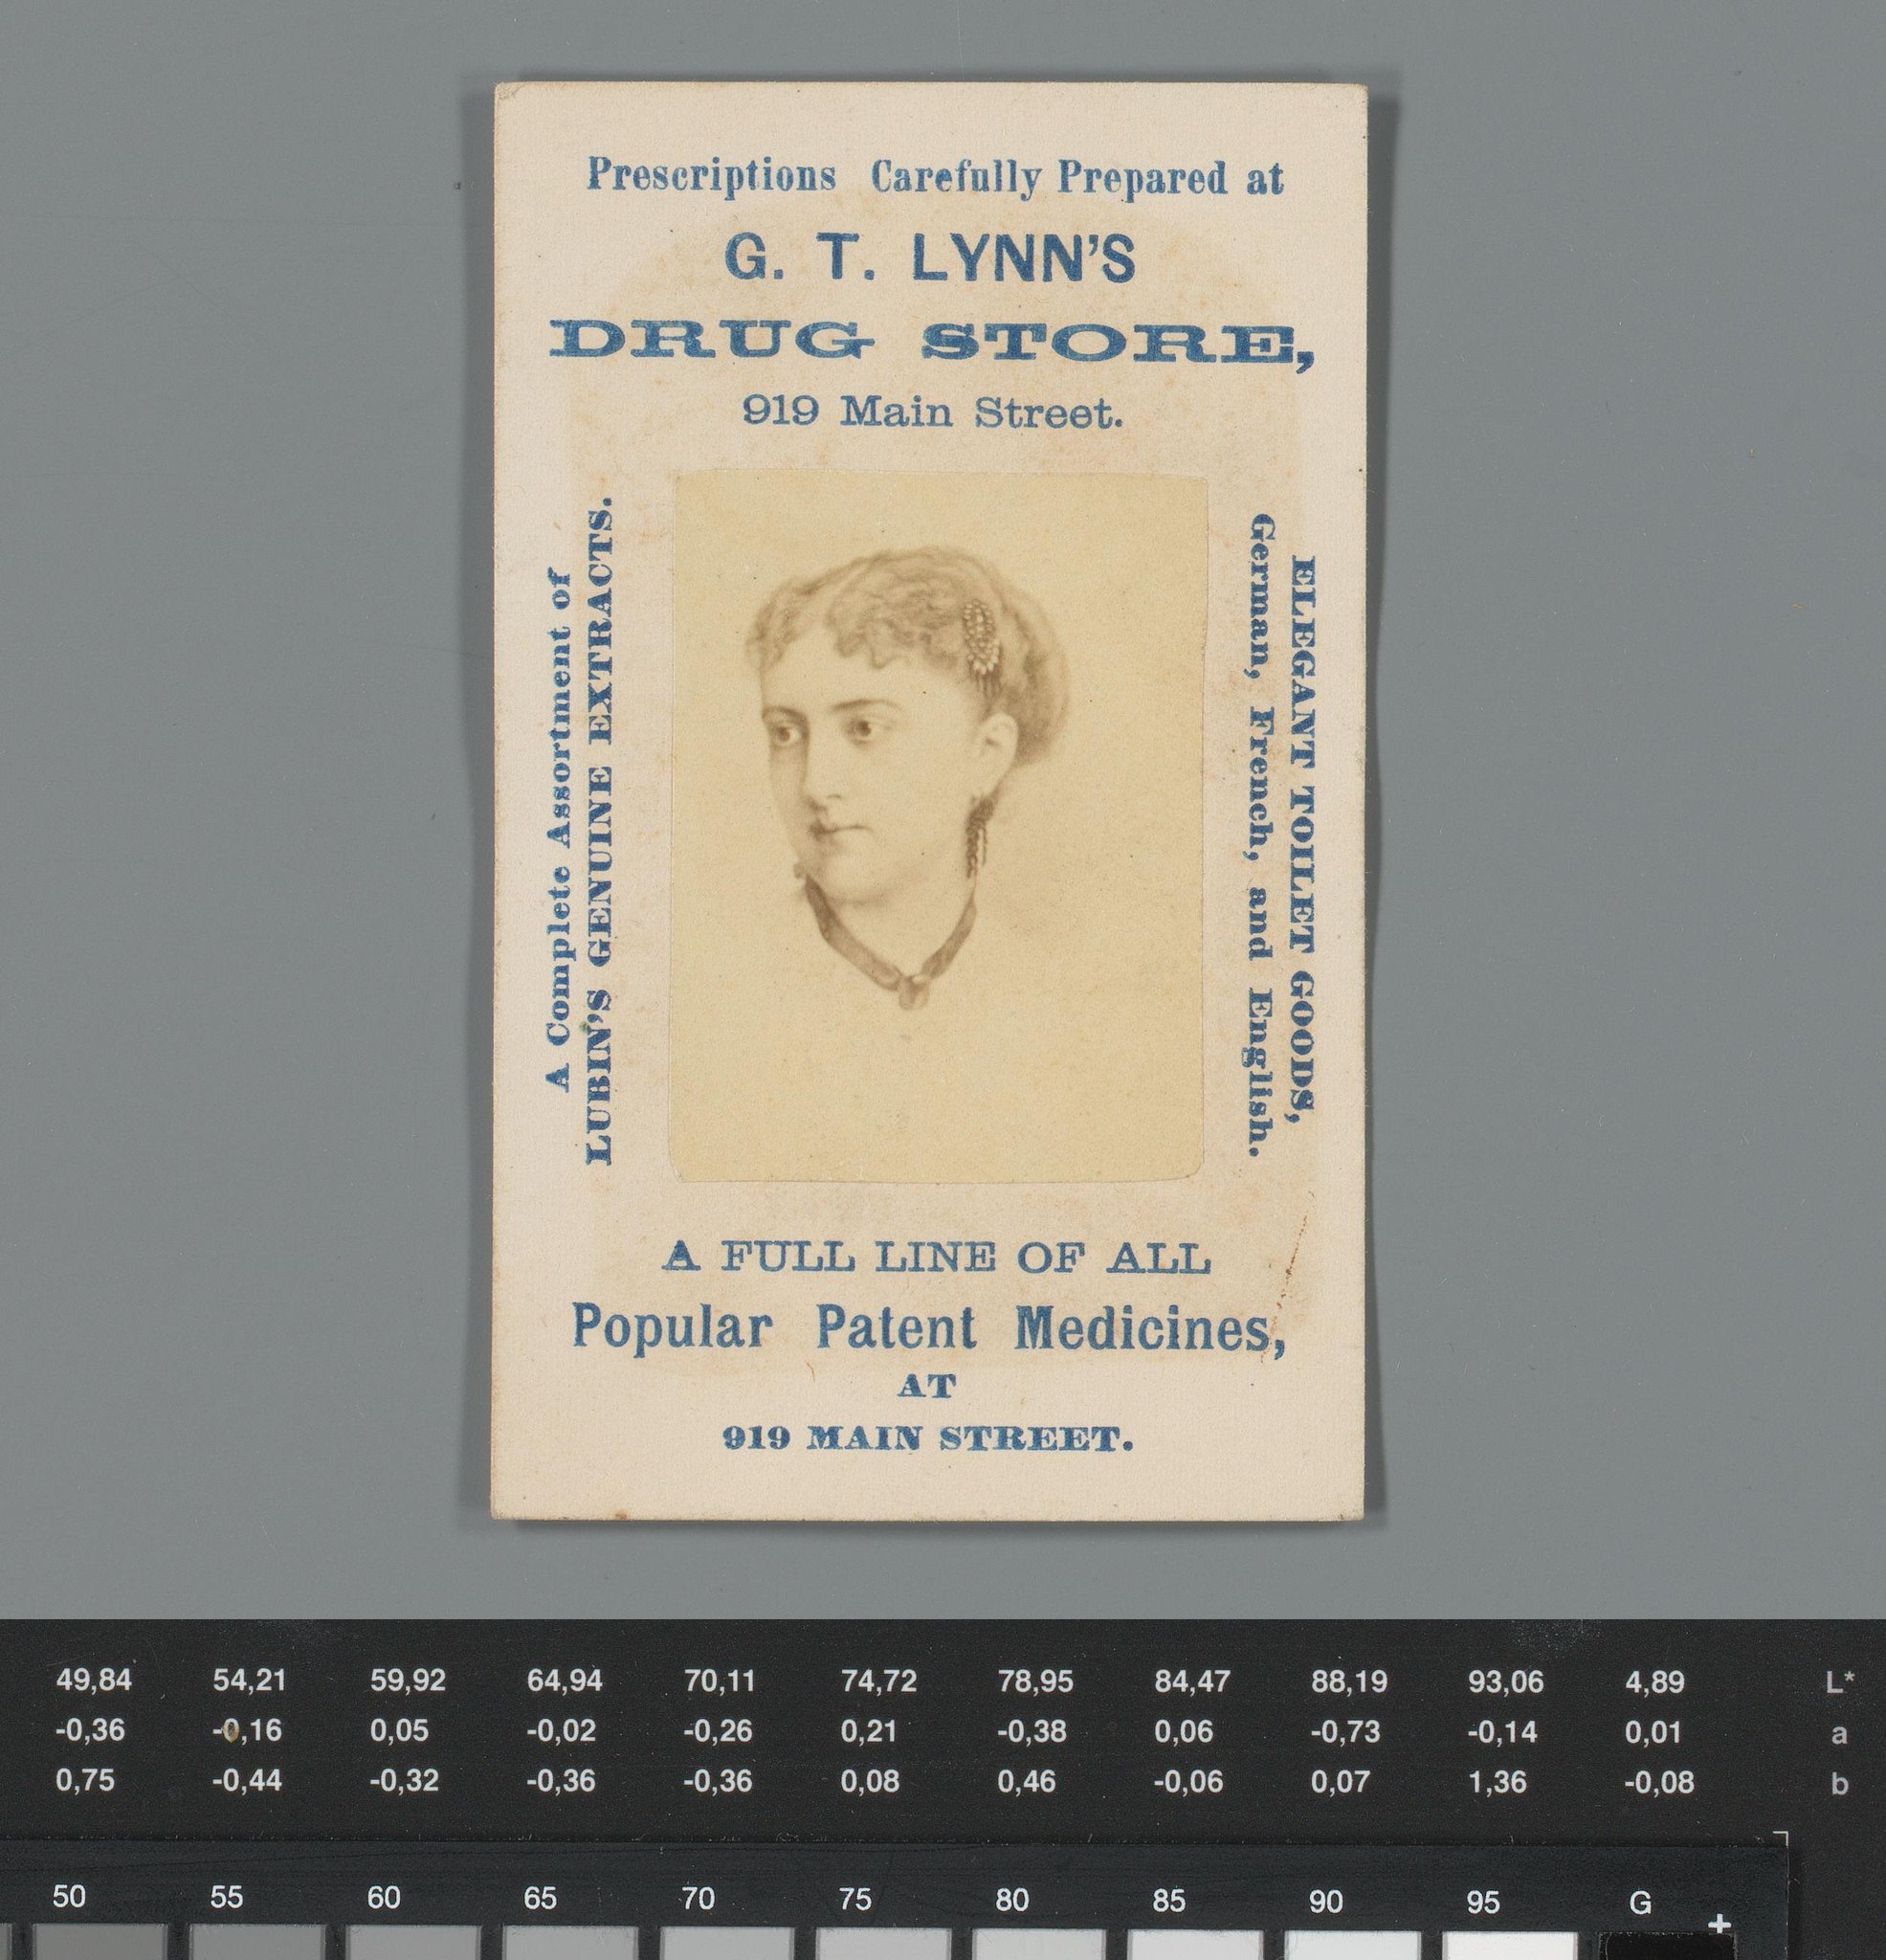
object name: carte de visite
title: Reclame voor de drogisterij van George T. Lynn in Kansas City, Missouri, met portret van een onbekende vrouw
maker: Anonymous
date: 1850-1915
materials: cardboard, photographic support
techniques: albumen print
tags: advertising, historical persons not known by name - bb - woman, pharmacy, pharmaceutics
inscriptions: inscription: ‘(...)’